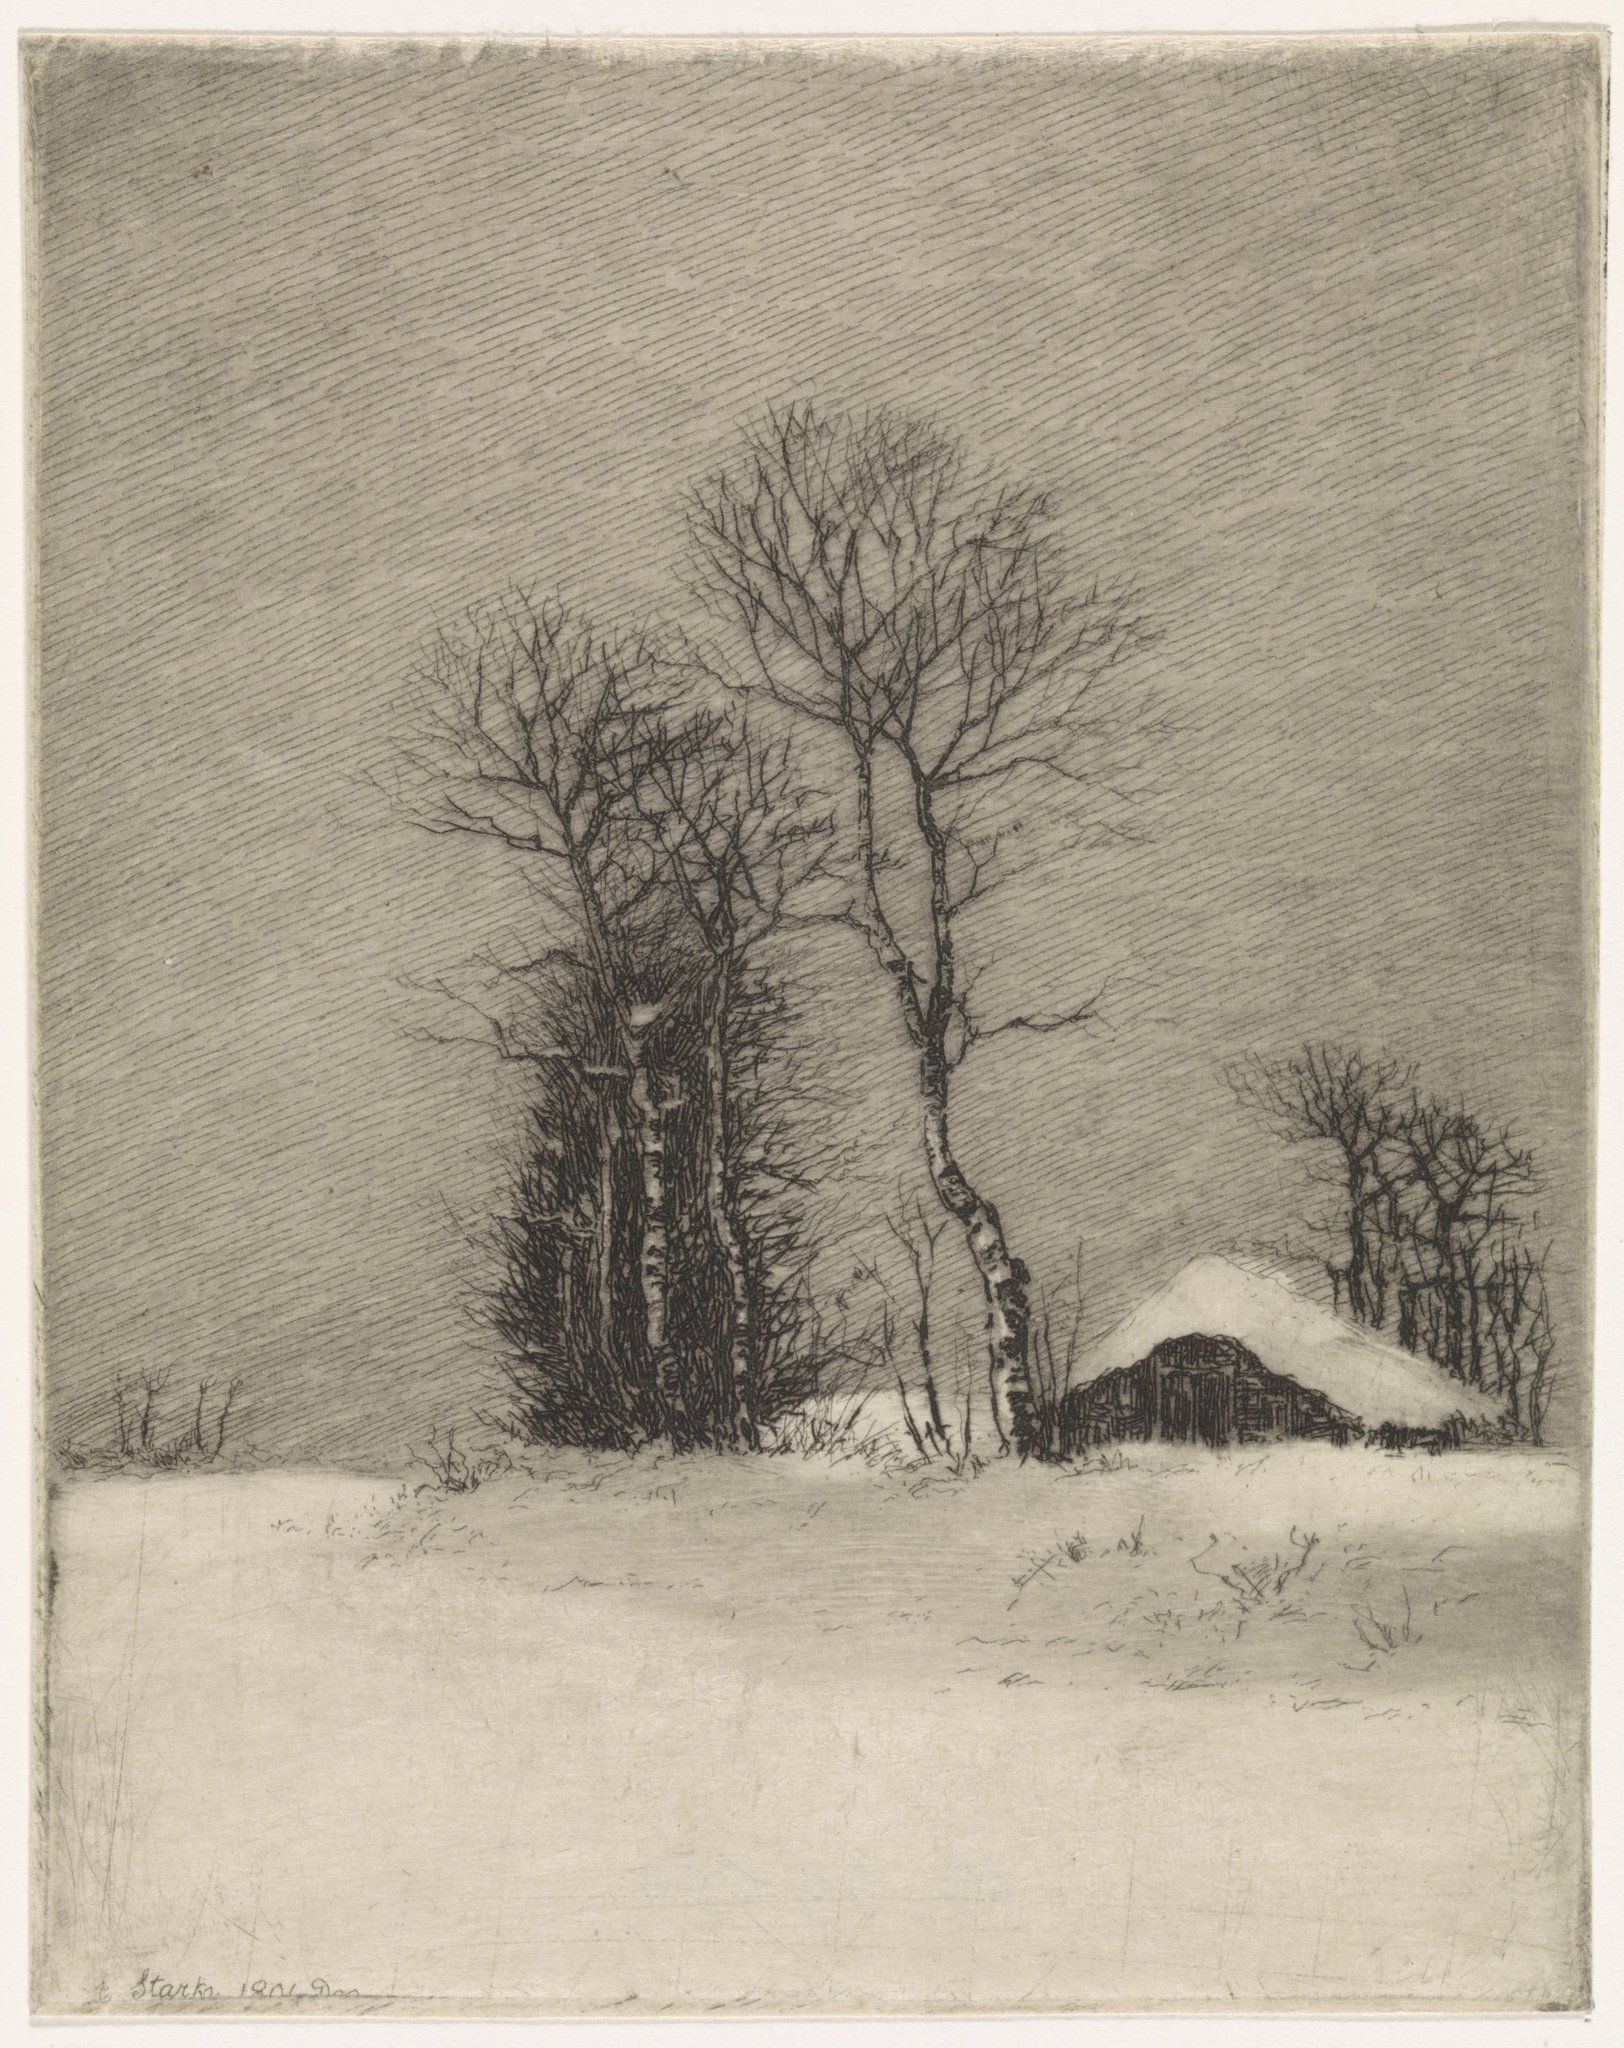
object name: print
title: Winterlandschap met boerderij en bomen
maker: elias stark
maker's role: draughtsman, print maker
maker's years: 1849-1933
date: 1812-1891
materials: paper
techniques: aquatint, etching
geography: nieuwer-amstel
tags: snow, farm or solitary house in landscape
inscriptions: collector's mark: Lugt 2228